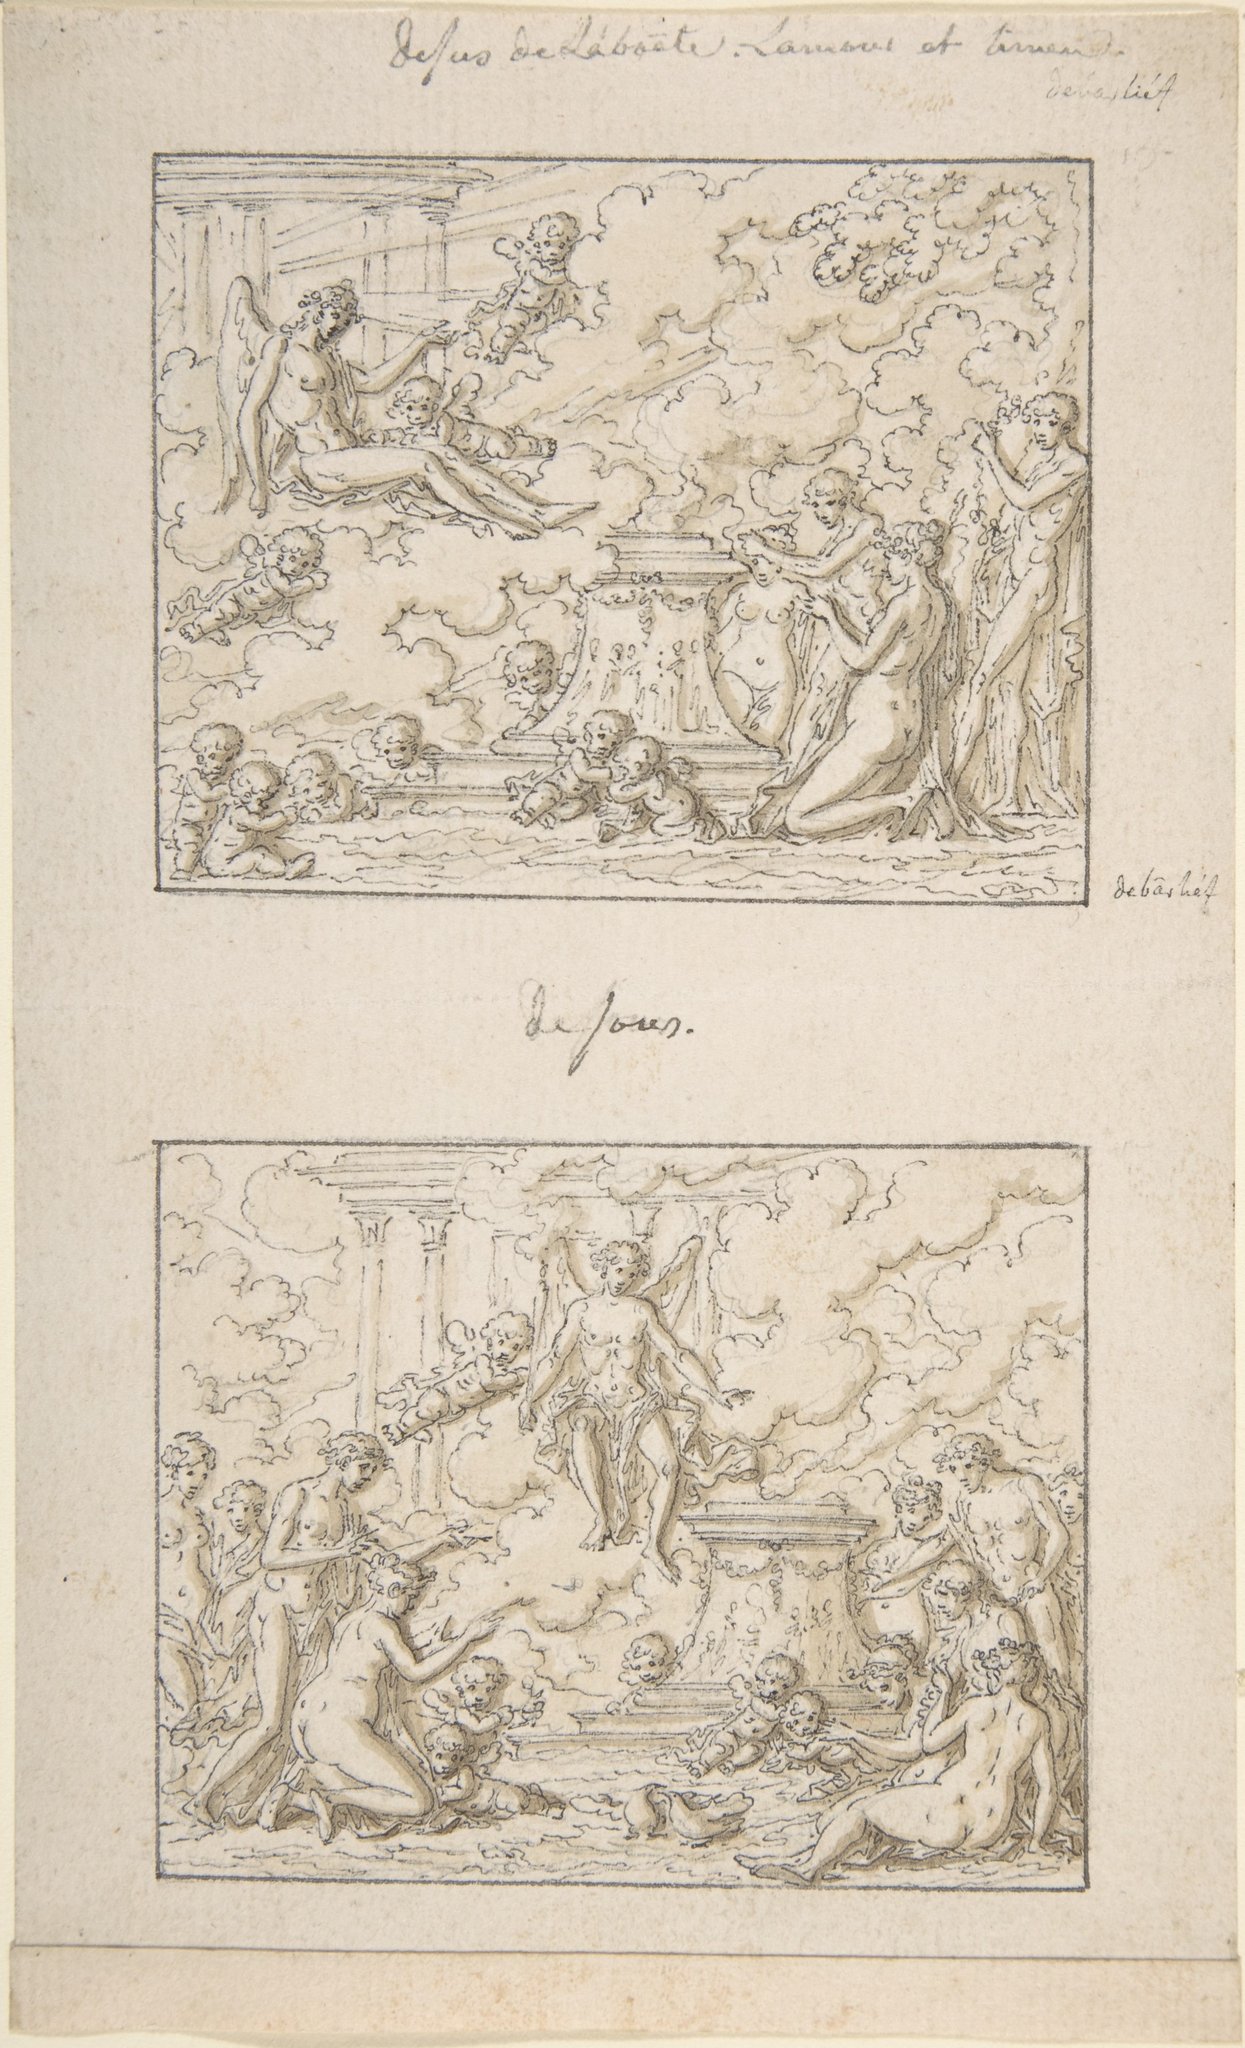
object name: drawing ornament architecture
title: Designs for the Top and Bottom of a Small Rectangular Box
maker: louis félix de la rue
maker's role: artist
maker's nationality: french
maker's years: 1731-1765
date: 1730-1777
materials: chalk, ink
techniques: brush, pen, wash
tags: female nudes